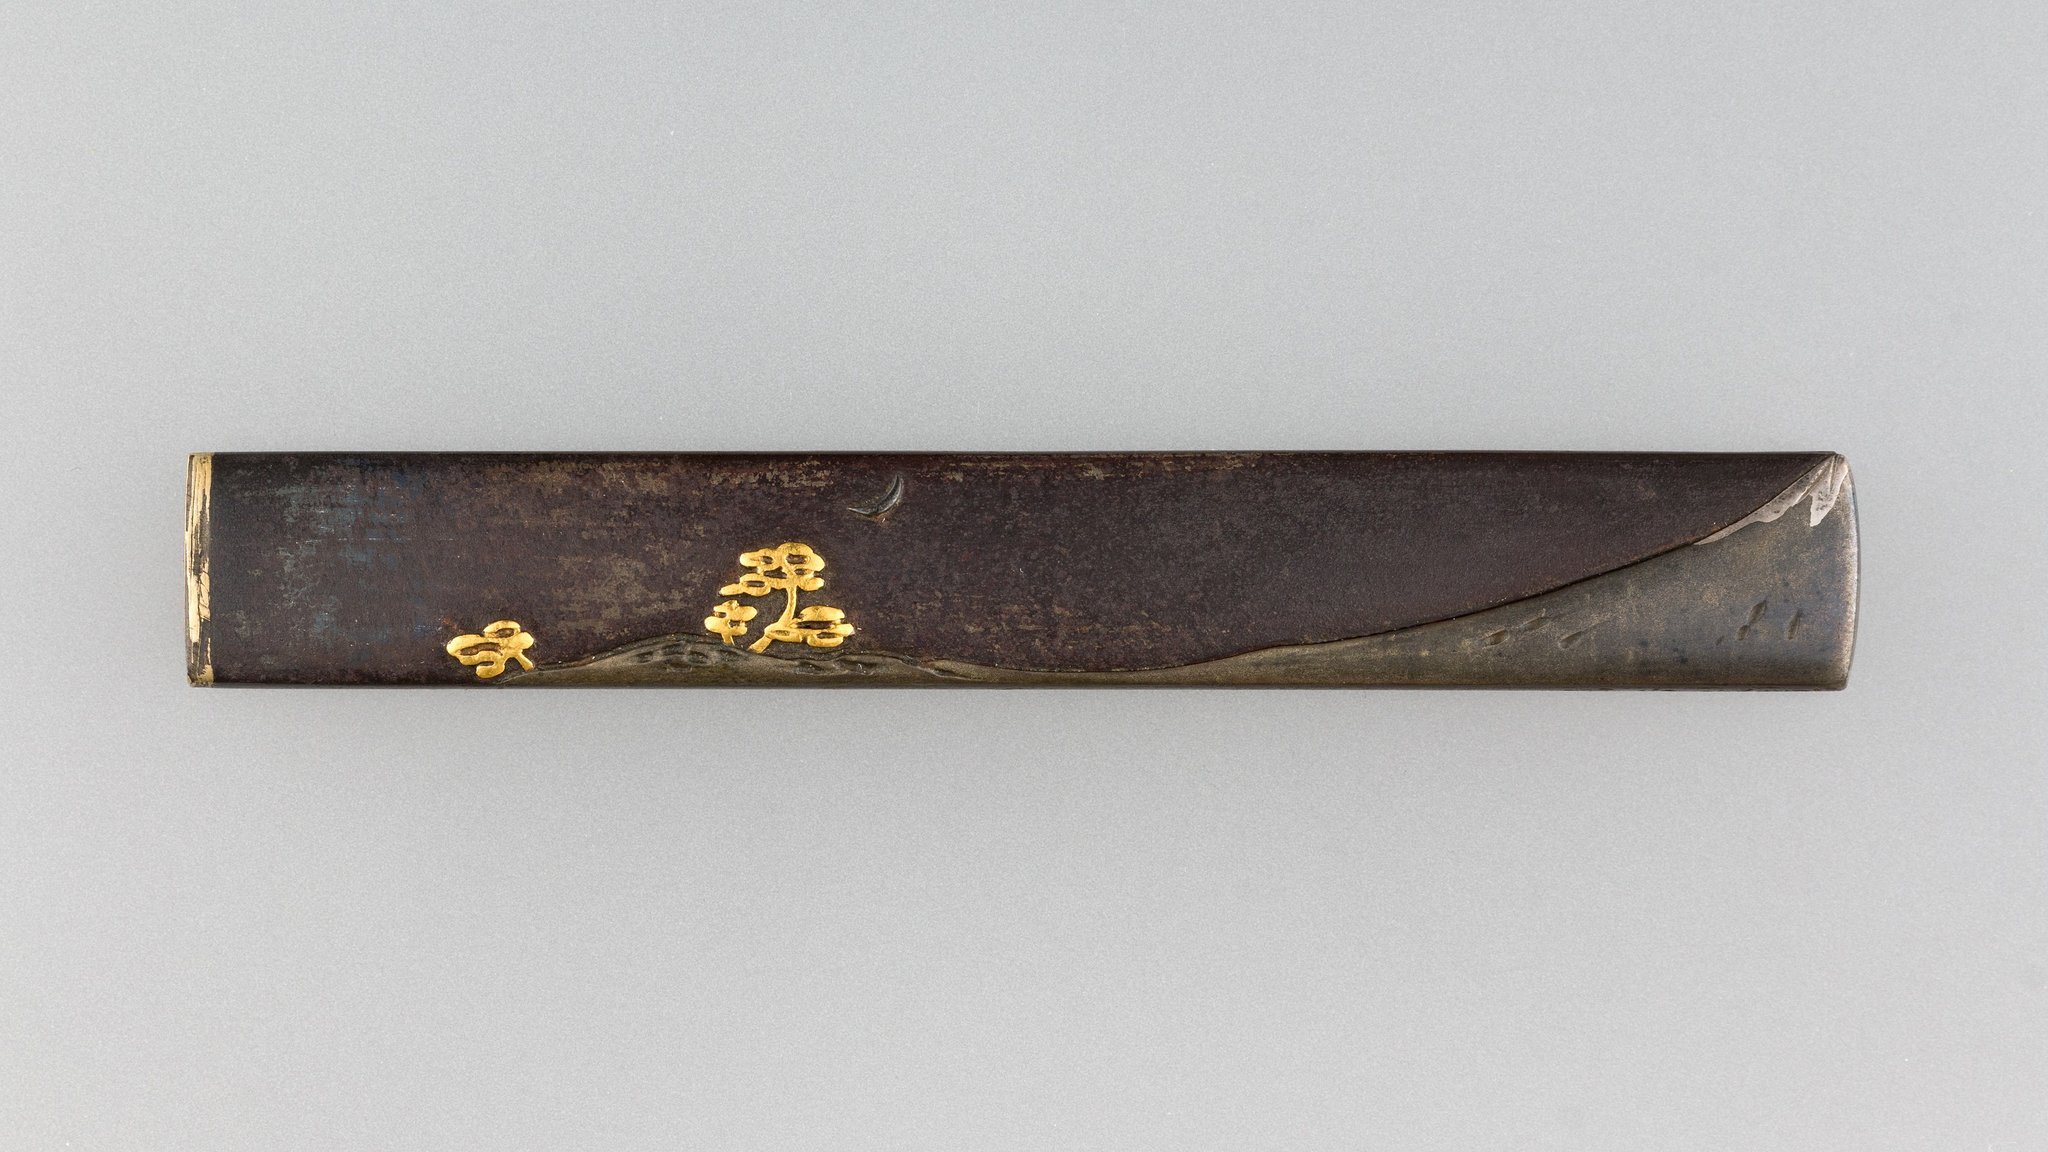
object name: knife handle kozuka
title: Knife Handle (Kozuka)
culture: japanese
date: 1701-1800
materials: silver alloy, gold, iron, silver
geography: japan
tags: mountains